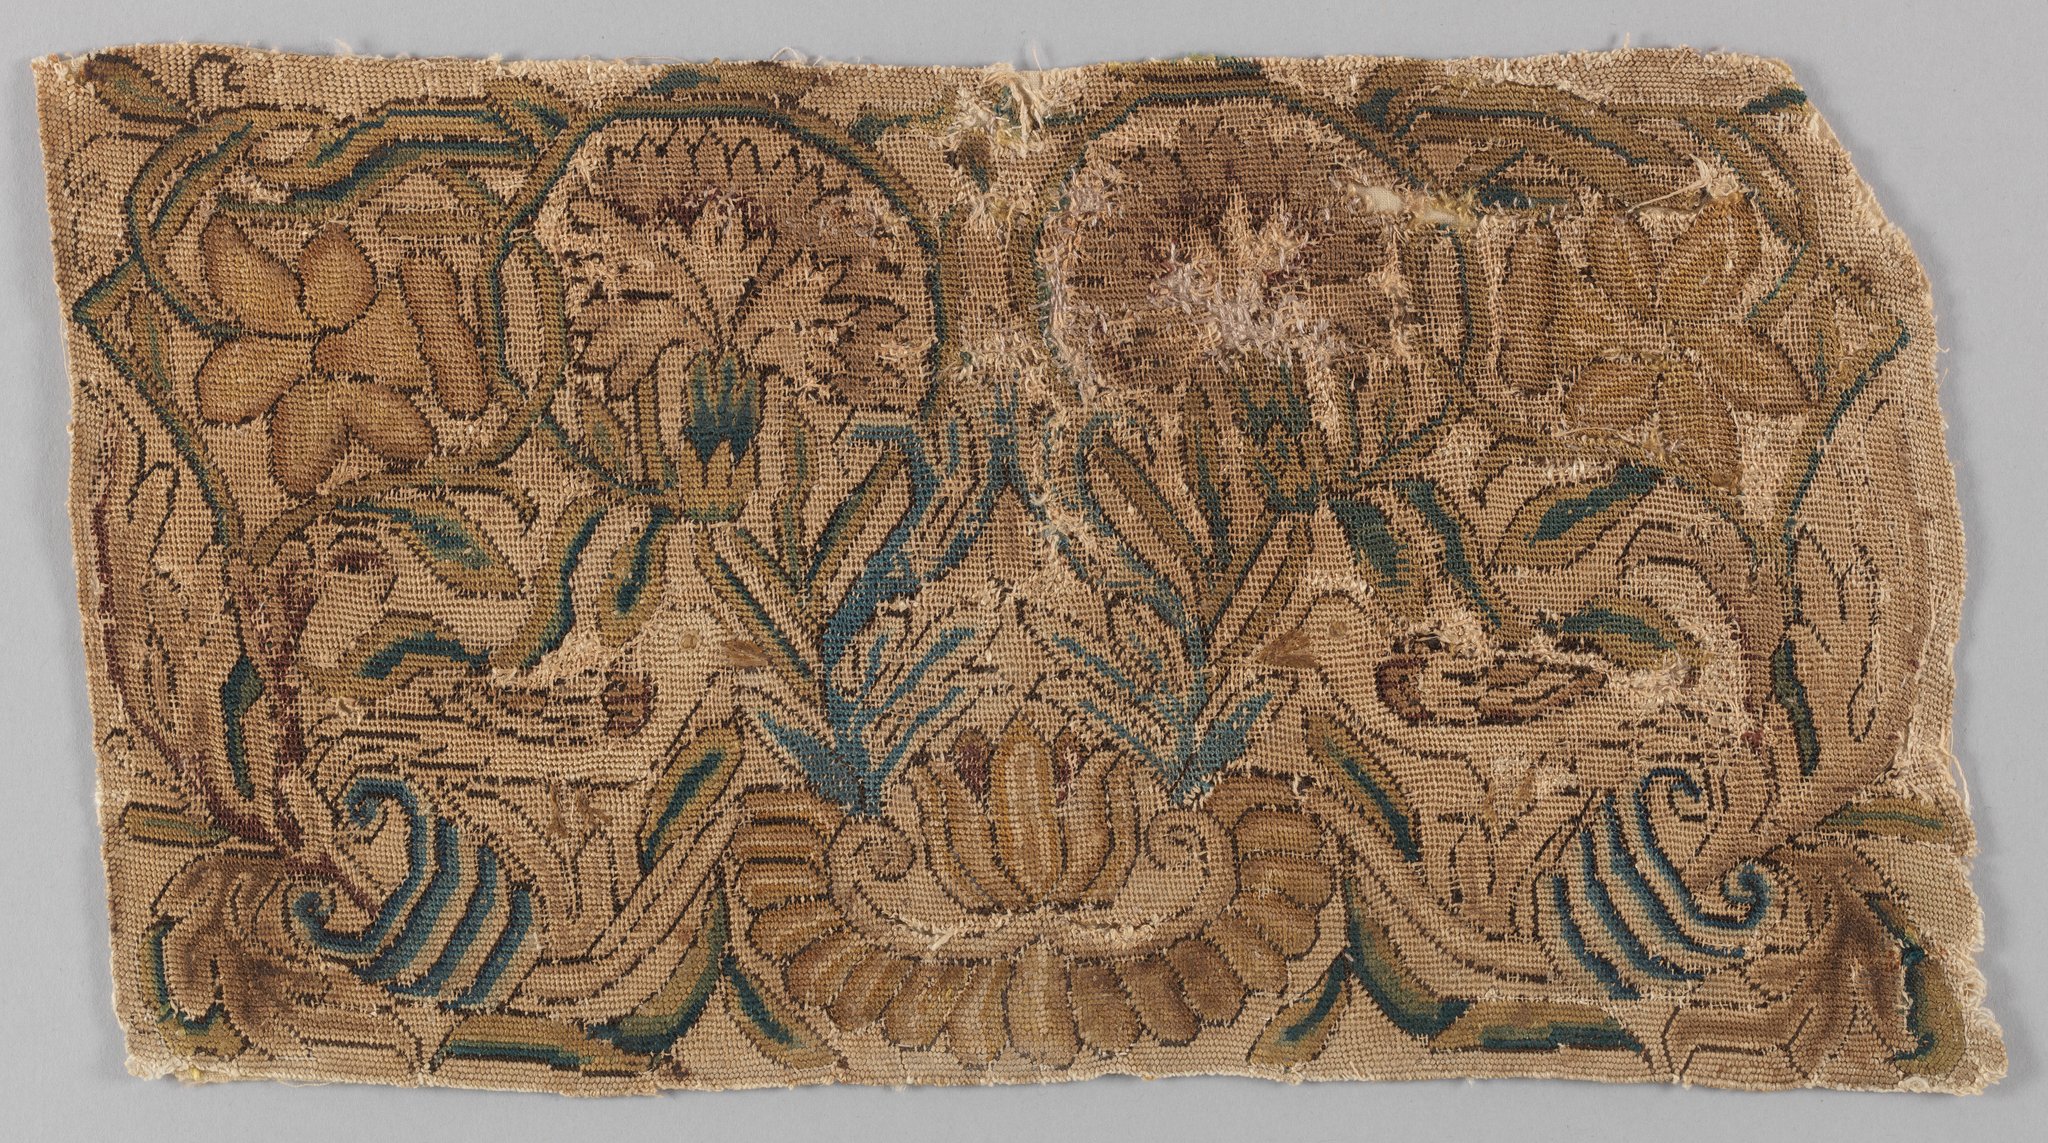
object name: piece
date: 1501-1600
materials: canvas, silk